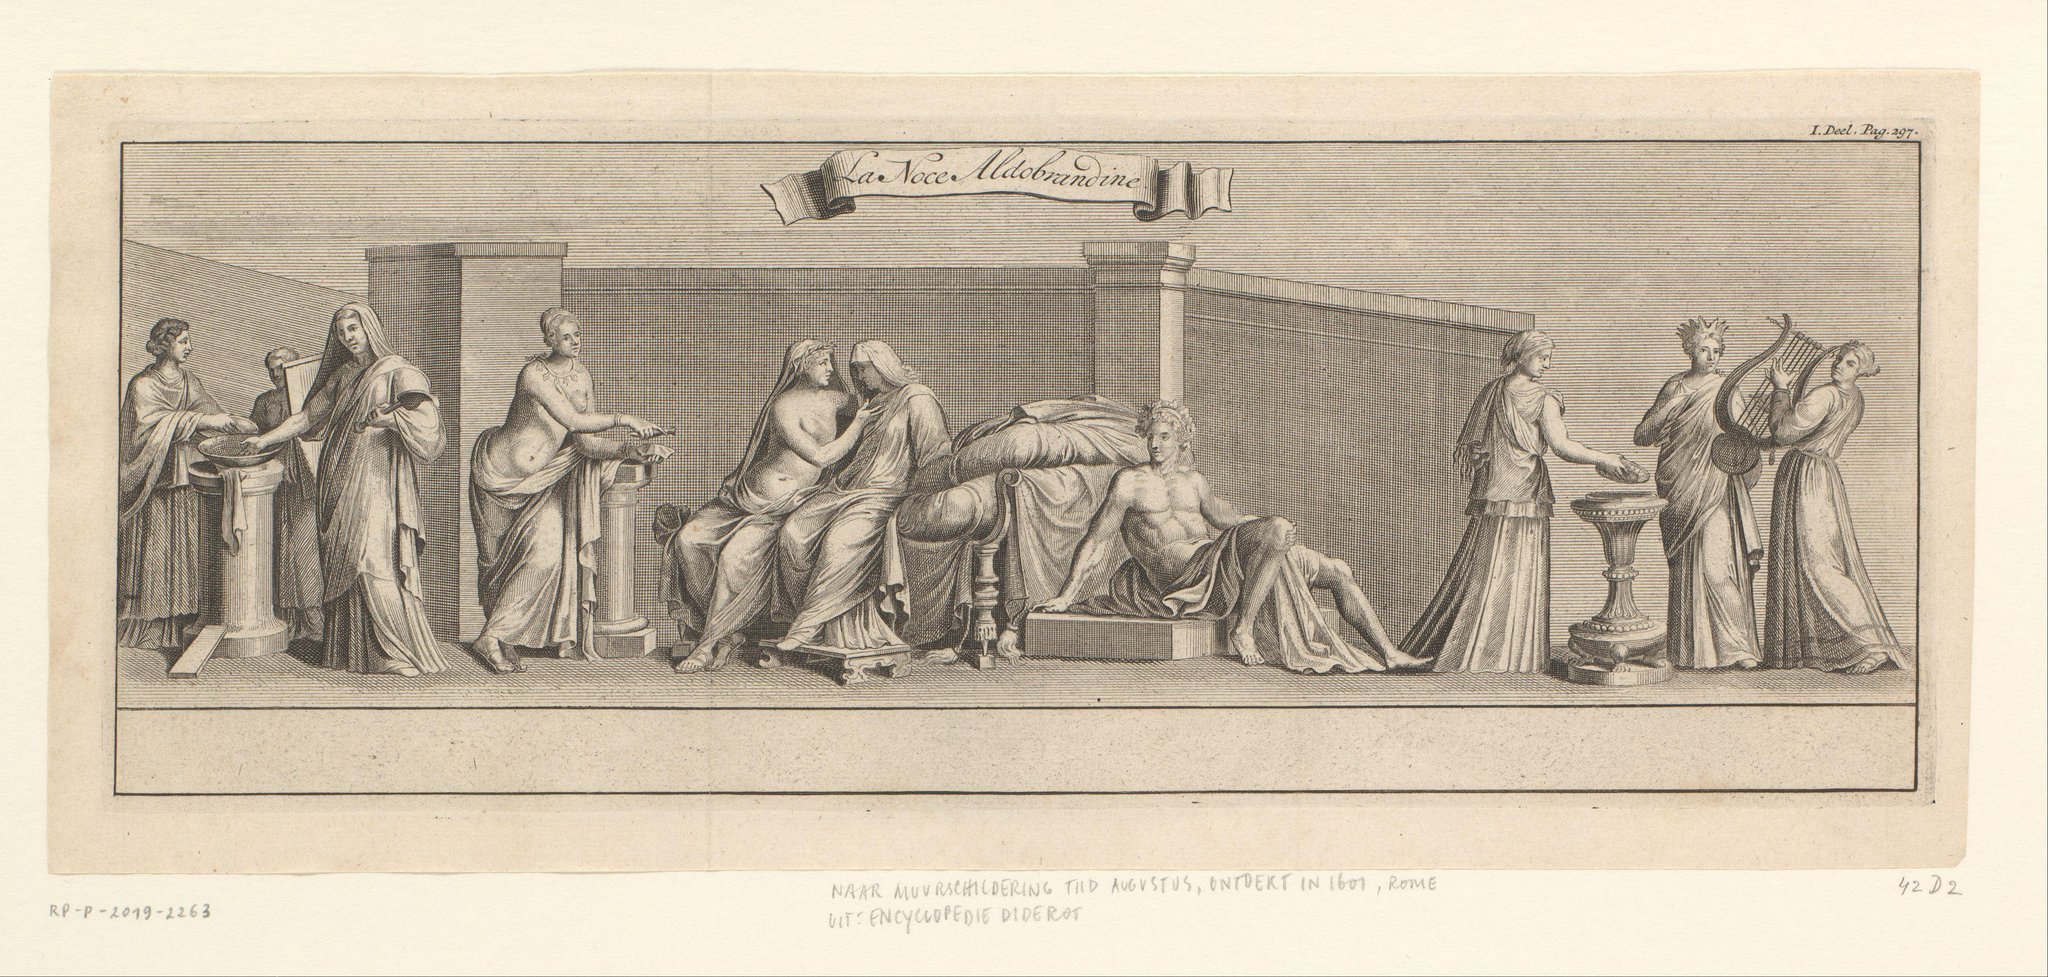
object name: print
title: La Noce Aldobrandine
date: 1751-1772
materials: paper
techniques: engraving, etching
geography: france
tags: civil marriage ceremony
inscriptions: collector's mark: Lugt 2228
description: Prent naar een muurschildering die ontdekt werd in Rome in 1601. Prent uit: Diderot, Denis. Encyclopédie ou dictionnaire raisonné des sciences, des arts et des métiers. s.l.s.n., 1751-1772, dl. 1, p. 297.